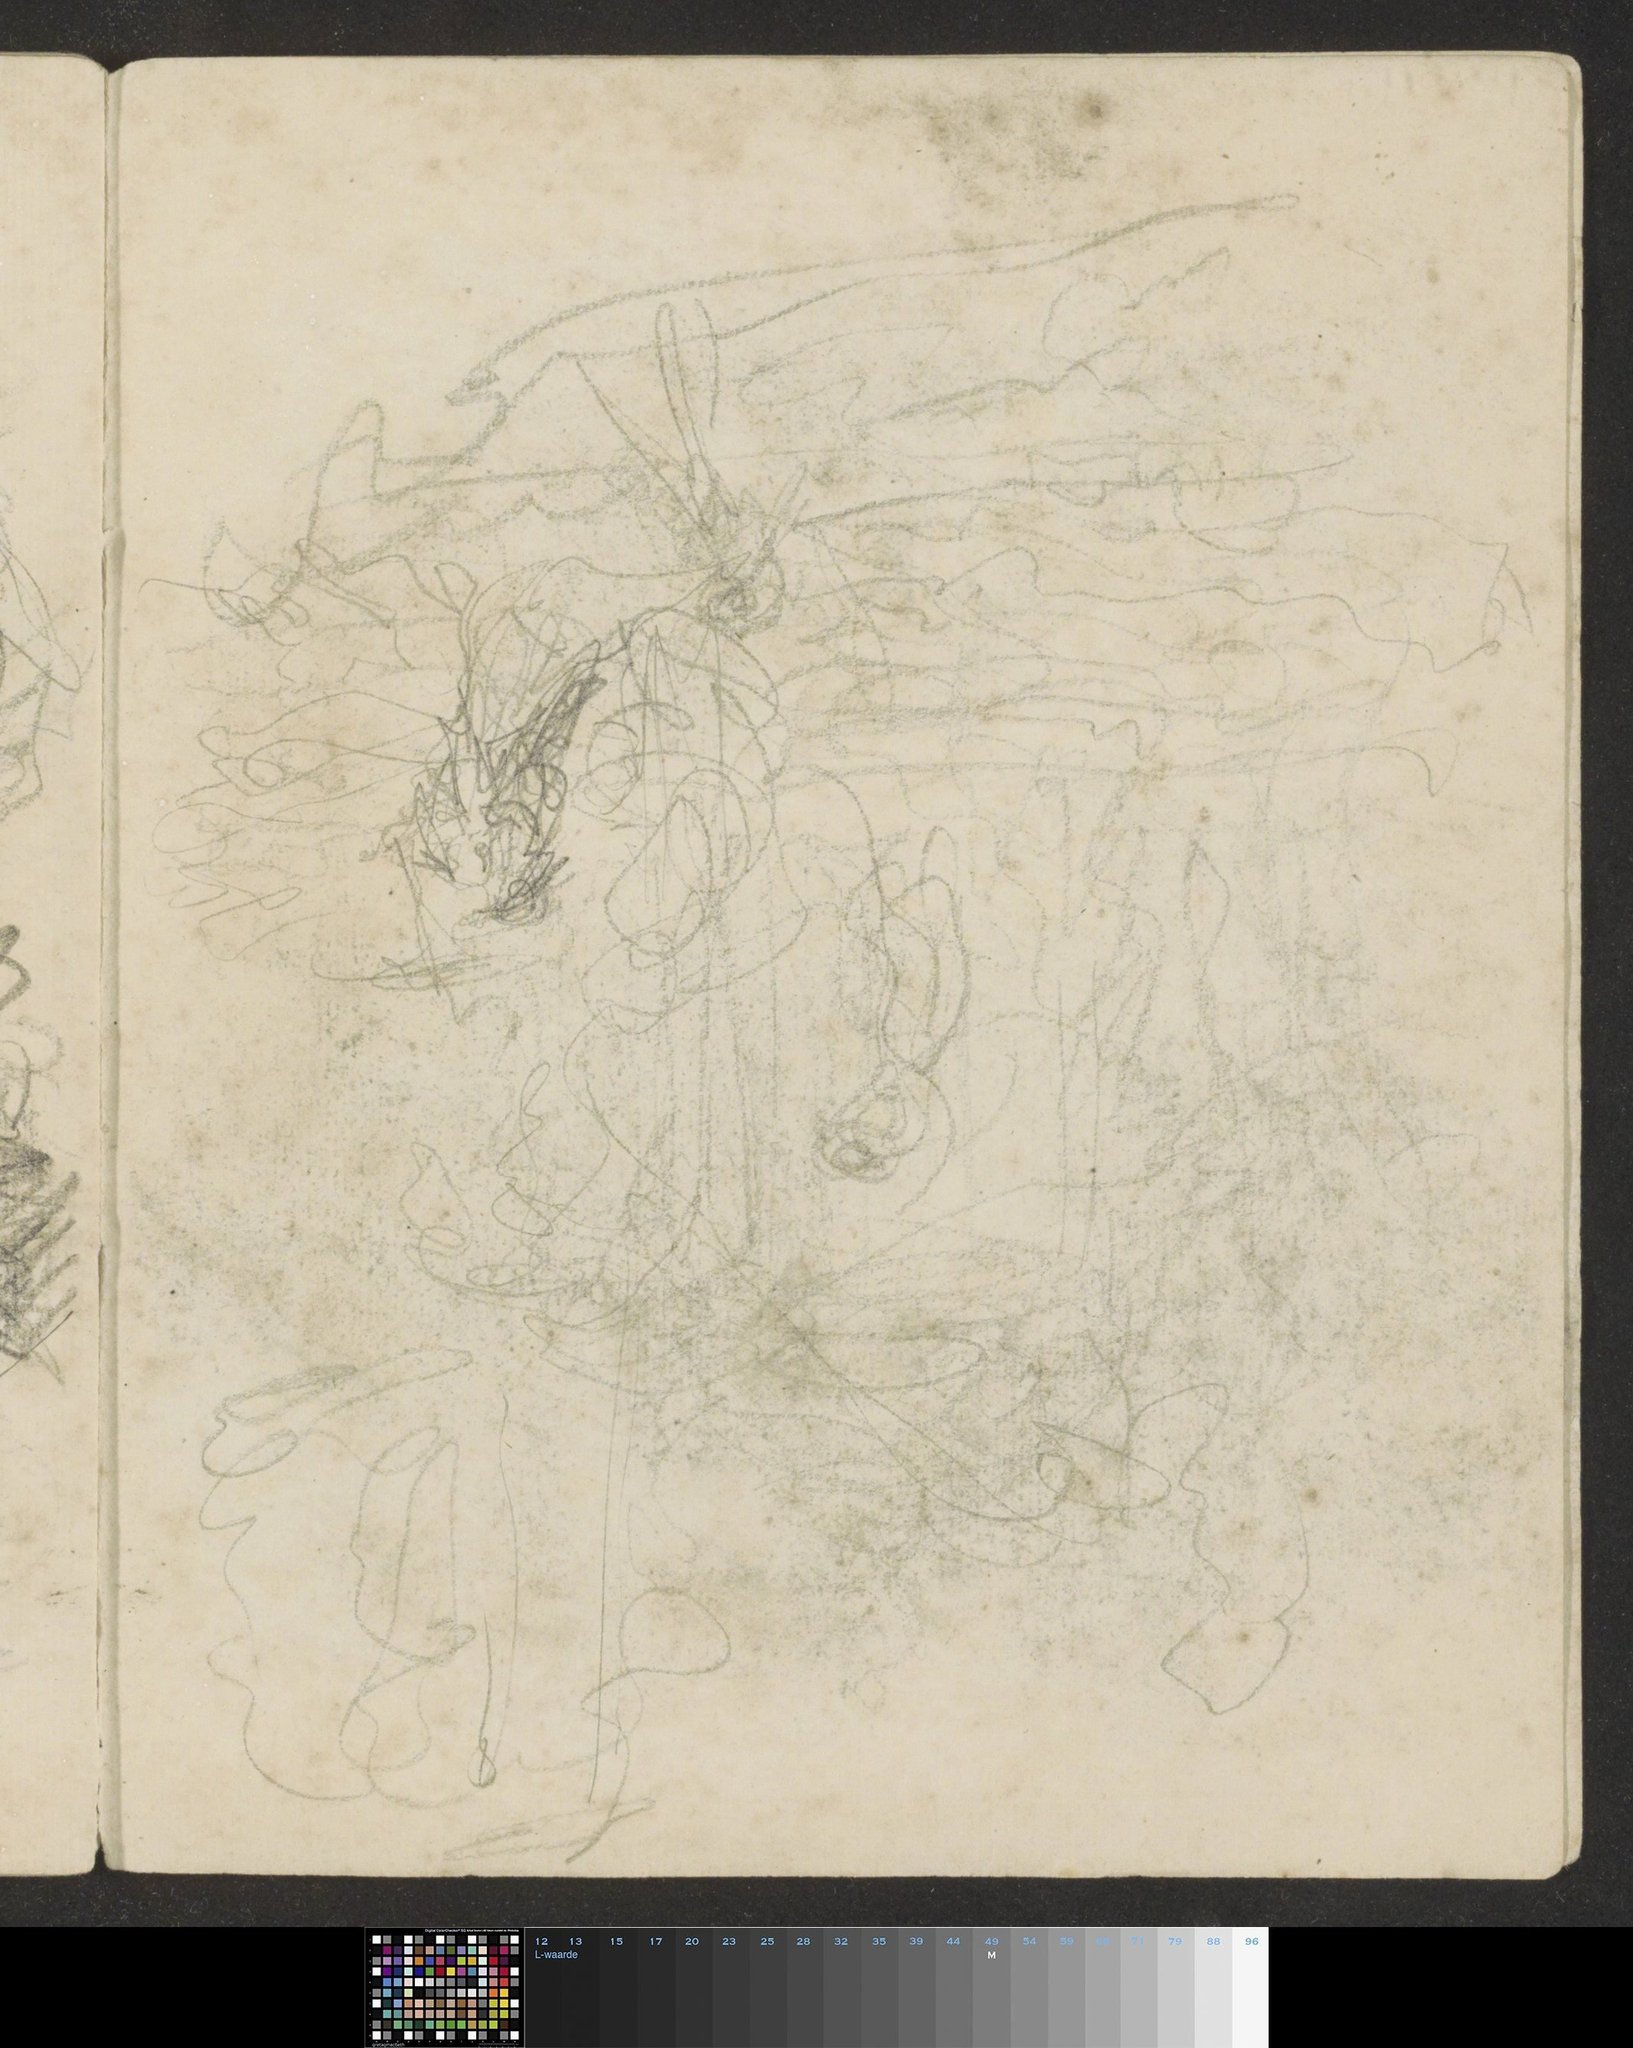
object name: sketchbook leaf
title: Landschap met figuren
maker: maria vos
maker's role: draughtsman, painter, print maker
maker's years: 1824-1906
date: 1834-1906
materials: paper, pencil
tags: landscapes (+ landscape with figures, staffage)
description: Blad 21 recto uit een schetsboek met 21 bladen.